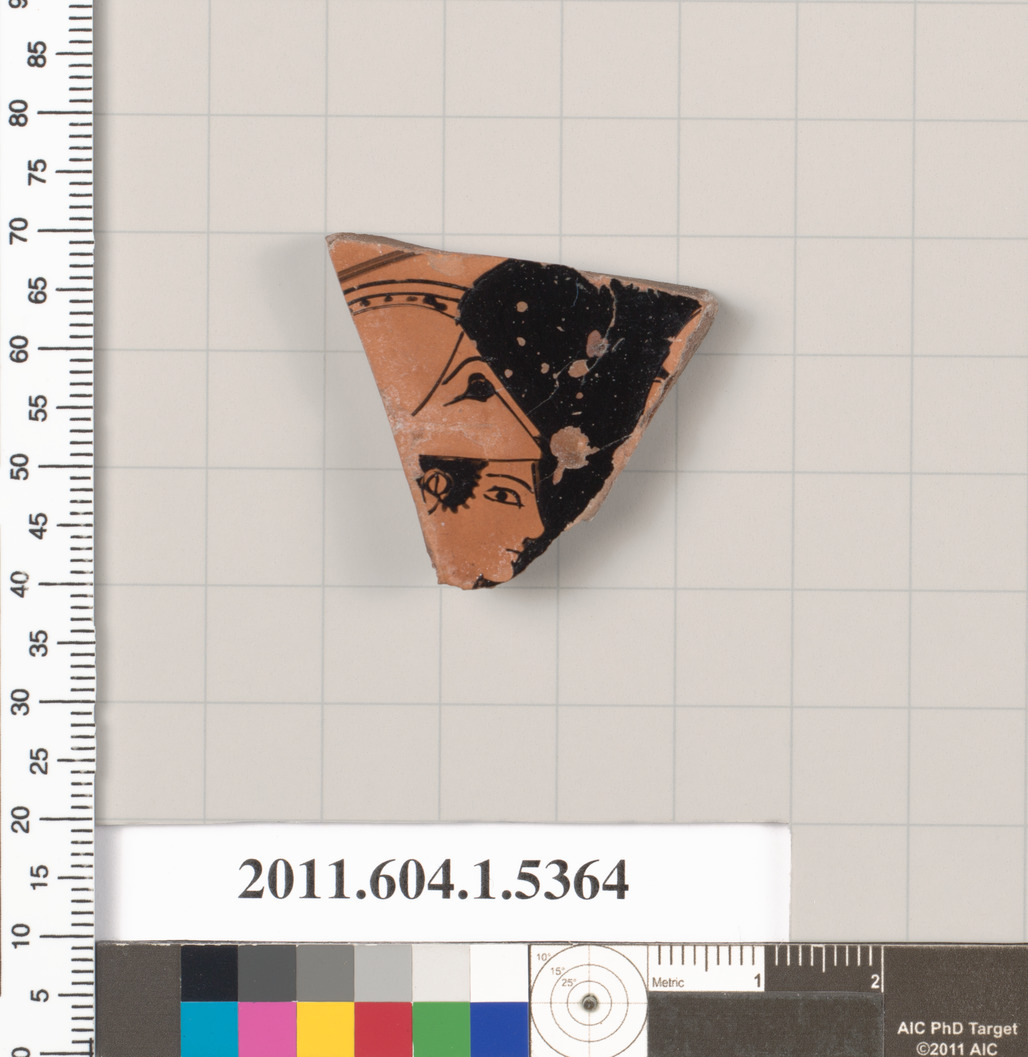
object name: kylix fragment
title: Terracotta fragment of a kylix (drinking cup)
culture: greek, attic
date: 510-500 BCE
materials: terracotta